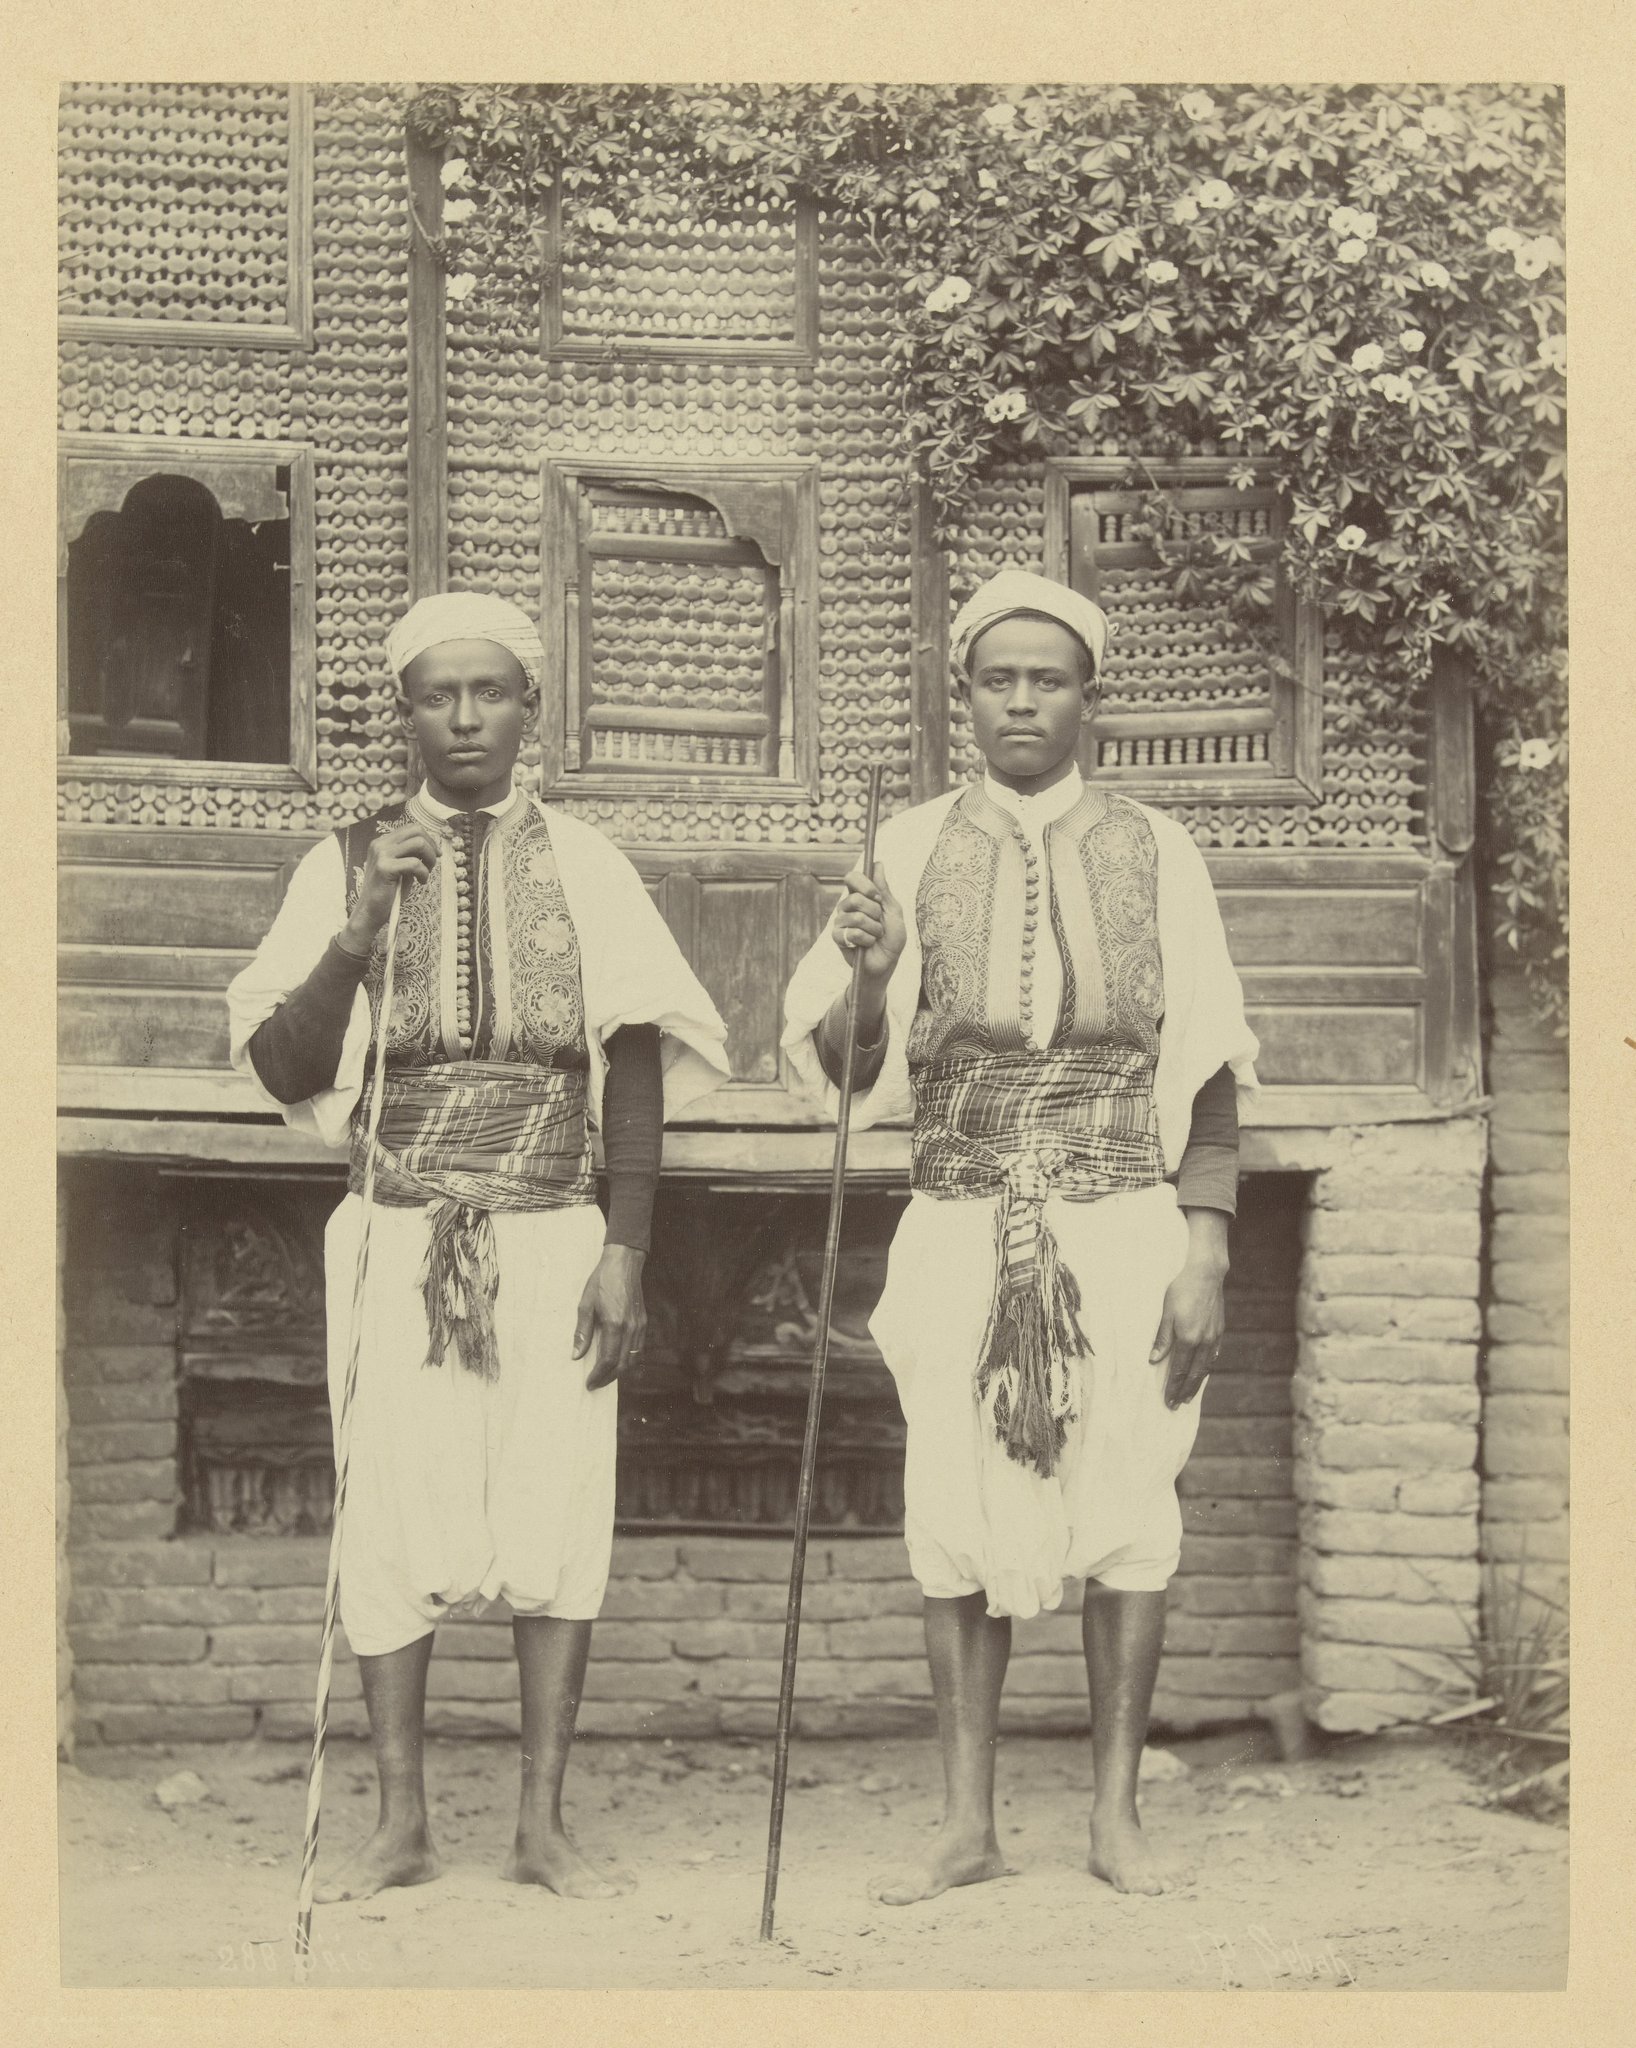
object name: photograph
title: Portret van twee onbekende jongemannen in uniform, Caïro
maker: jean pascal sébah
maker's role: fotograaf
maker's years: 1872-1947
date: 1888-1895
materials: cardboard, paper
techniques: albumen print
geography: cairo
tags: (military) uniforms, historical persons not known by name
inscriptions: title: ‘E 19. Saïs (voorloopers). Caïro.’, number: ‘288’, check stamp: ‘Bristol/ L.M.’, stamp: ‘Gemeentelijke bibliotheek/ Rotterdam’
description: Onderdeel van een groep door fotograaf Richard Polak op reis verzamelde foto’s. Deze foto is samen met andere op zijn reizen verzamelde foto's tentoongesteld bij de Rotterdamsche Kunstkring (1895), Arti en Amicitiae te Amsterdam (1897-1898?) en Societeit 't Collegie te Kampen (datum vooralsnog onbekend).